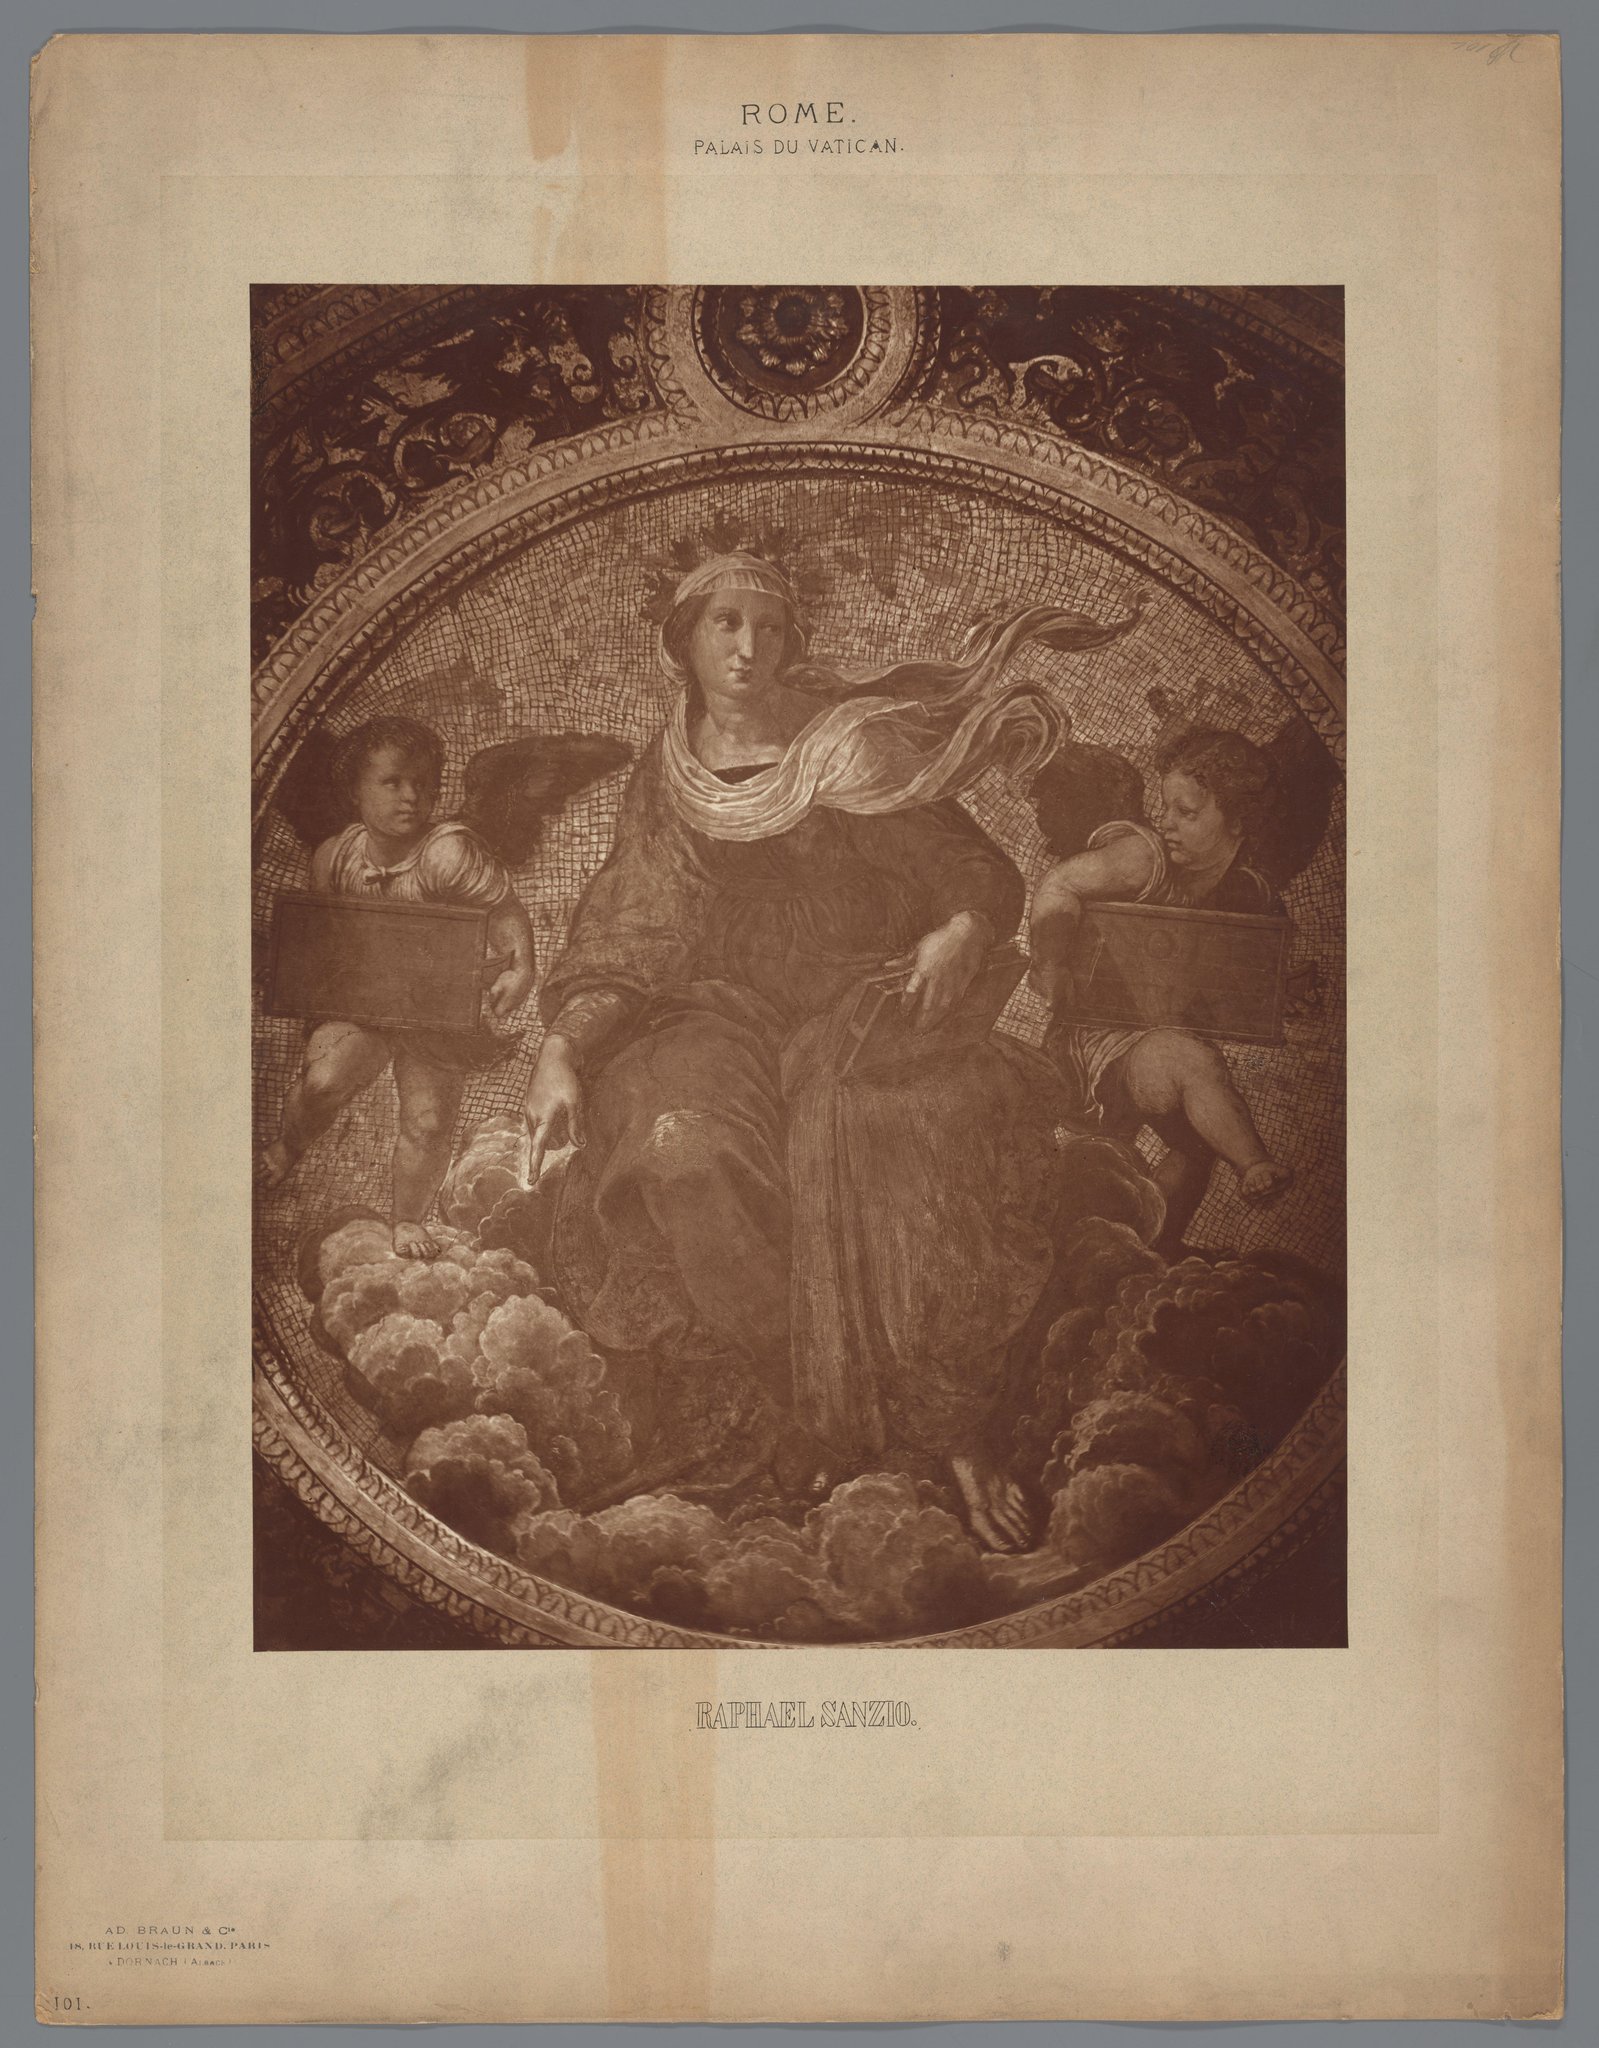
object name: photograph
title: Fotoreproductie van een mozaïek van (naar?) Rafaël (Vaticaanse Musea)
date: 1880-1900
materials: cardboard, paper, photographic support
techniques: carbon print